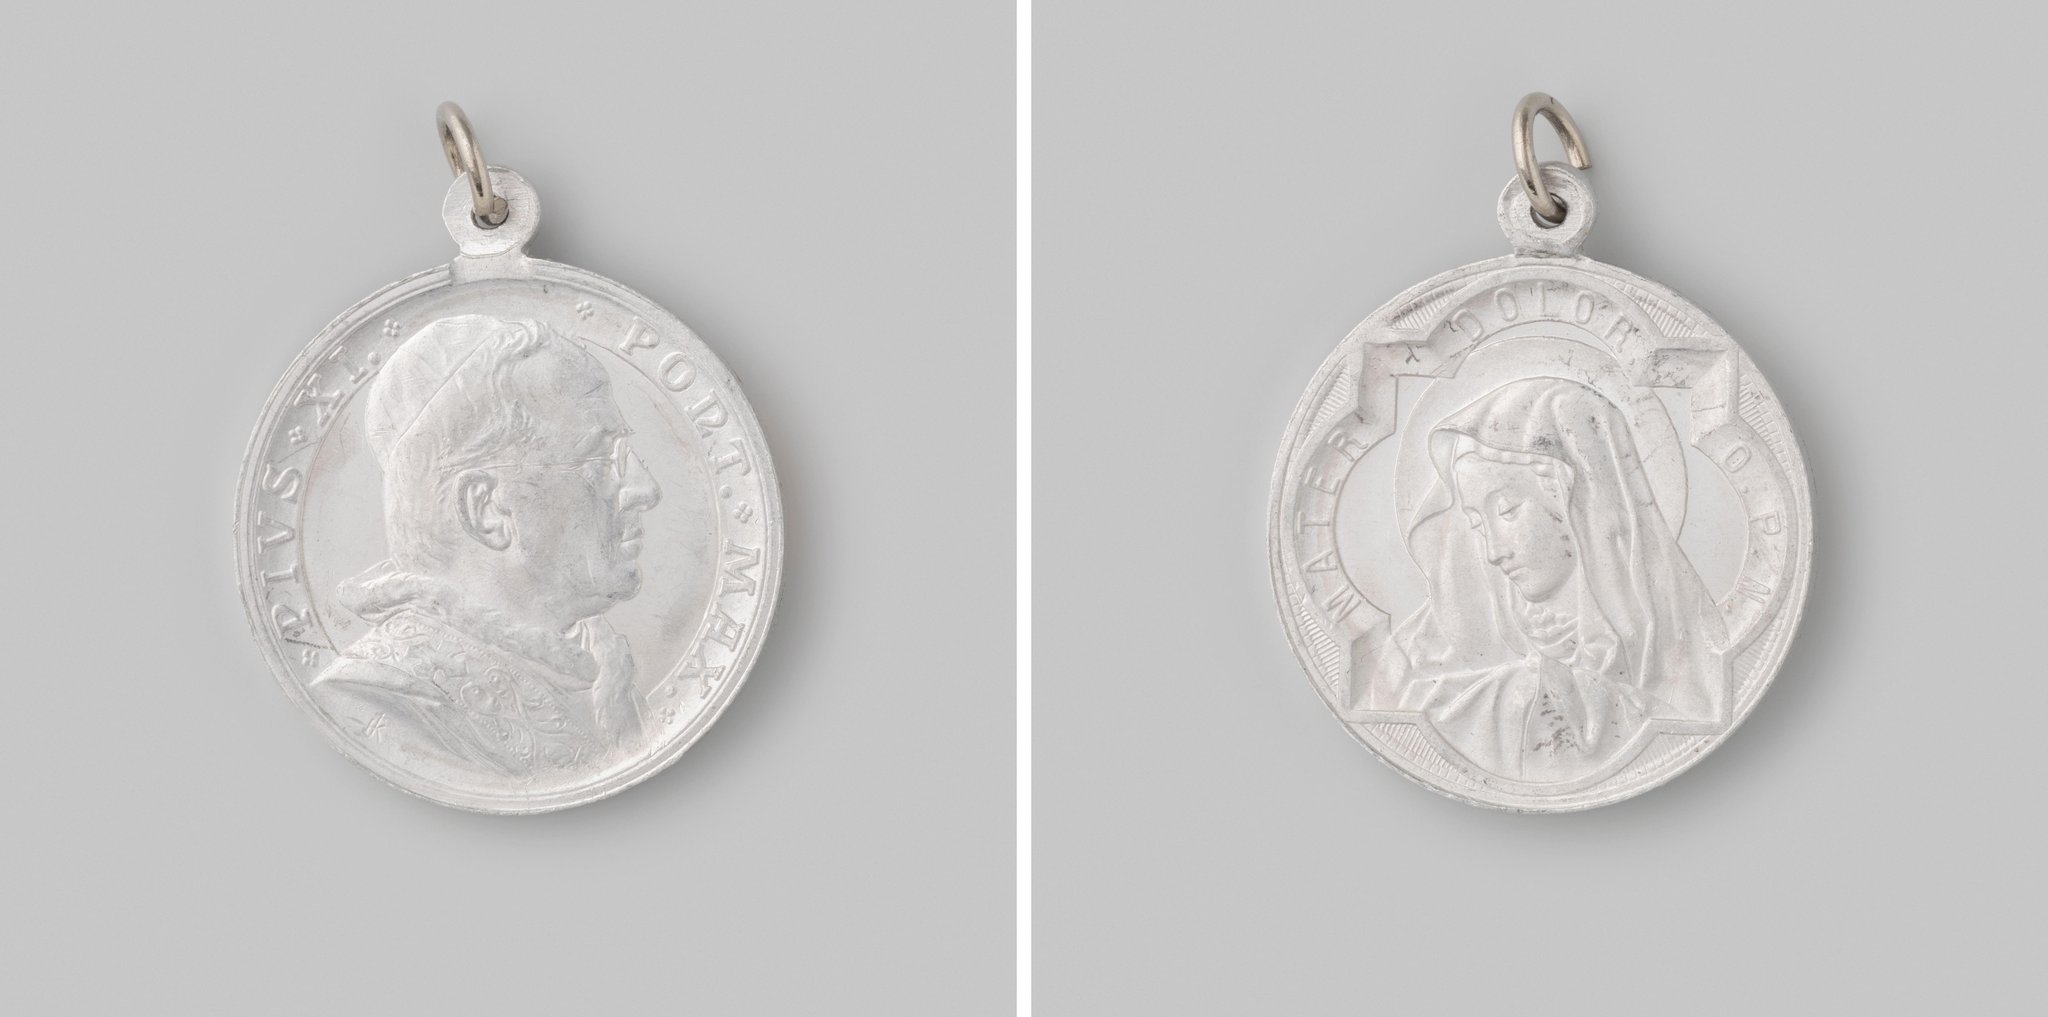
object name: history medal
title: Devotiepenning met portret Paus Pius XI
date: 1922-1939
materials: aluminum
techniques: striking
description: Aluminium penning met oog en draagring, op de voorzijde het borstbeeld van Pius naar rechts met omschrift, op de keerzijde het borstbeeld van Maria naar links binnen een vierpas, met omschrift.